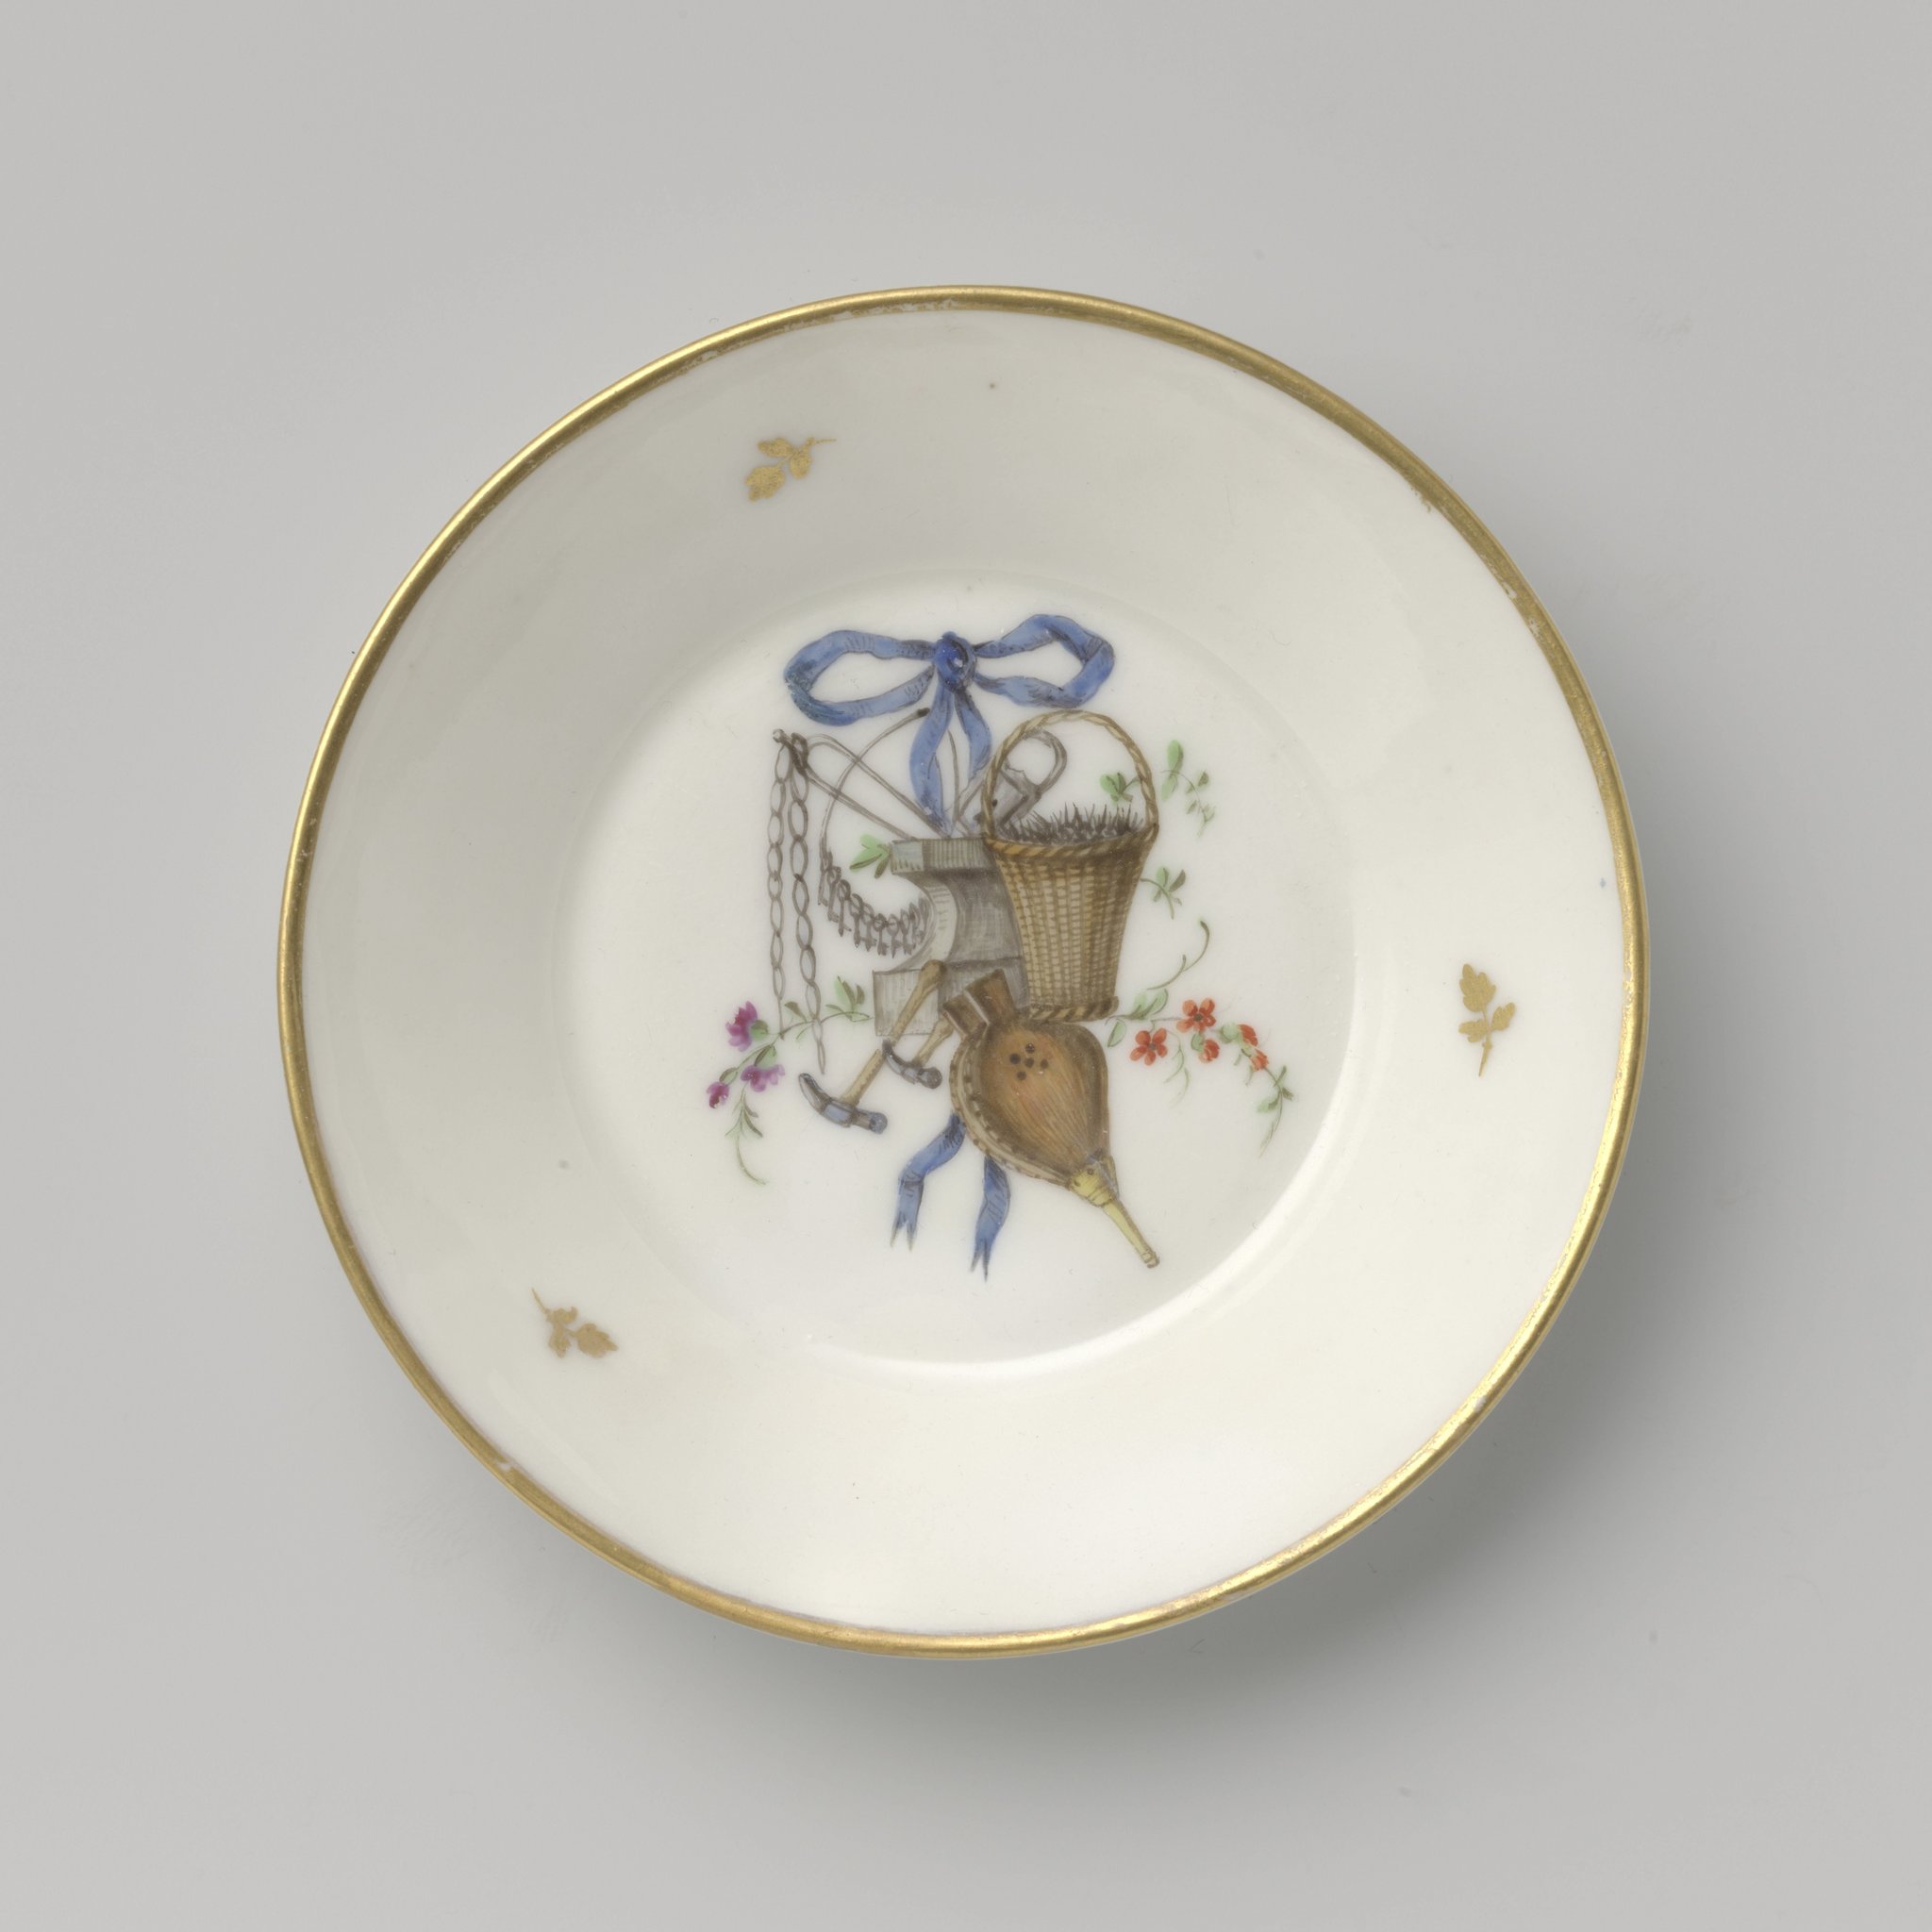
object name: platter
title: Schotel behorend bij een theeservies met decoratie van trofeeën aan gestrikte linten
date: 1809-1814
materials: porcelain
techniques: painted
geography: nieuwer-amstel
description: Theeservies bestaande uit een theepot, een suikerpot, een spoelkom en twaalf koppen en schotels veelkleurig beschilderd met trofeeën hangend aan blauwe strikken. De trofeeën hebben betrekking op diverse beroepen. Gemerkt in zwart: Amstel (de suikerpot Amstel N. 805 en ingegrift A). Verschillende ingegrifte merken in de koppen en schotels.